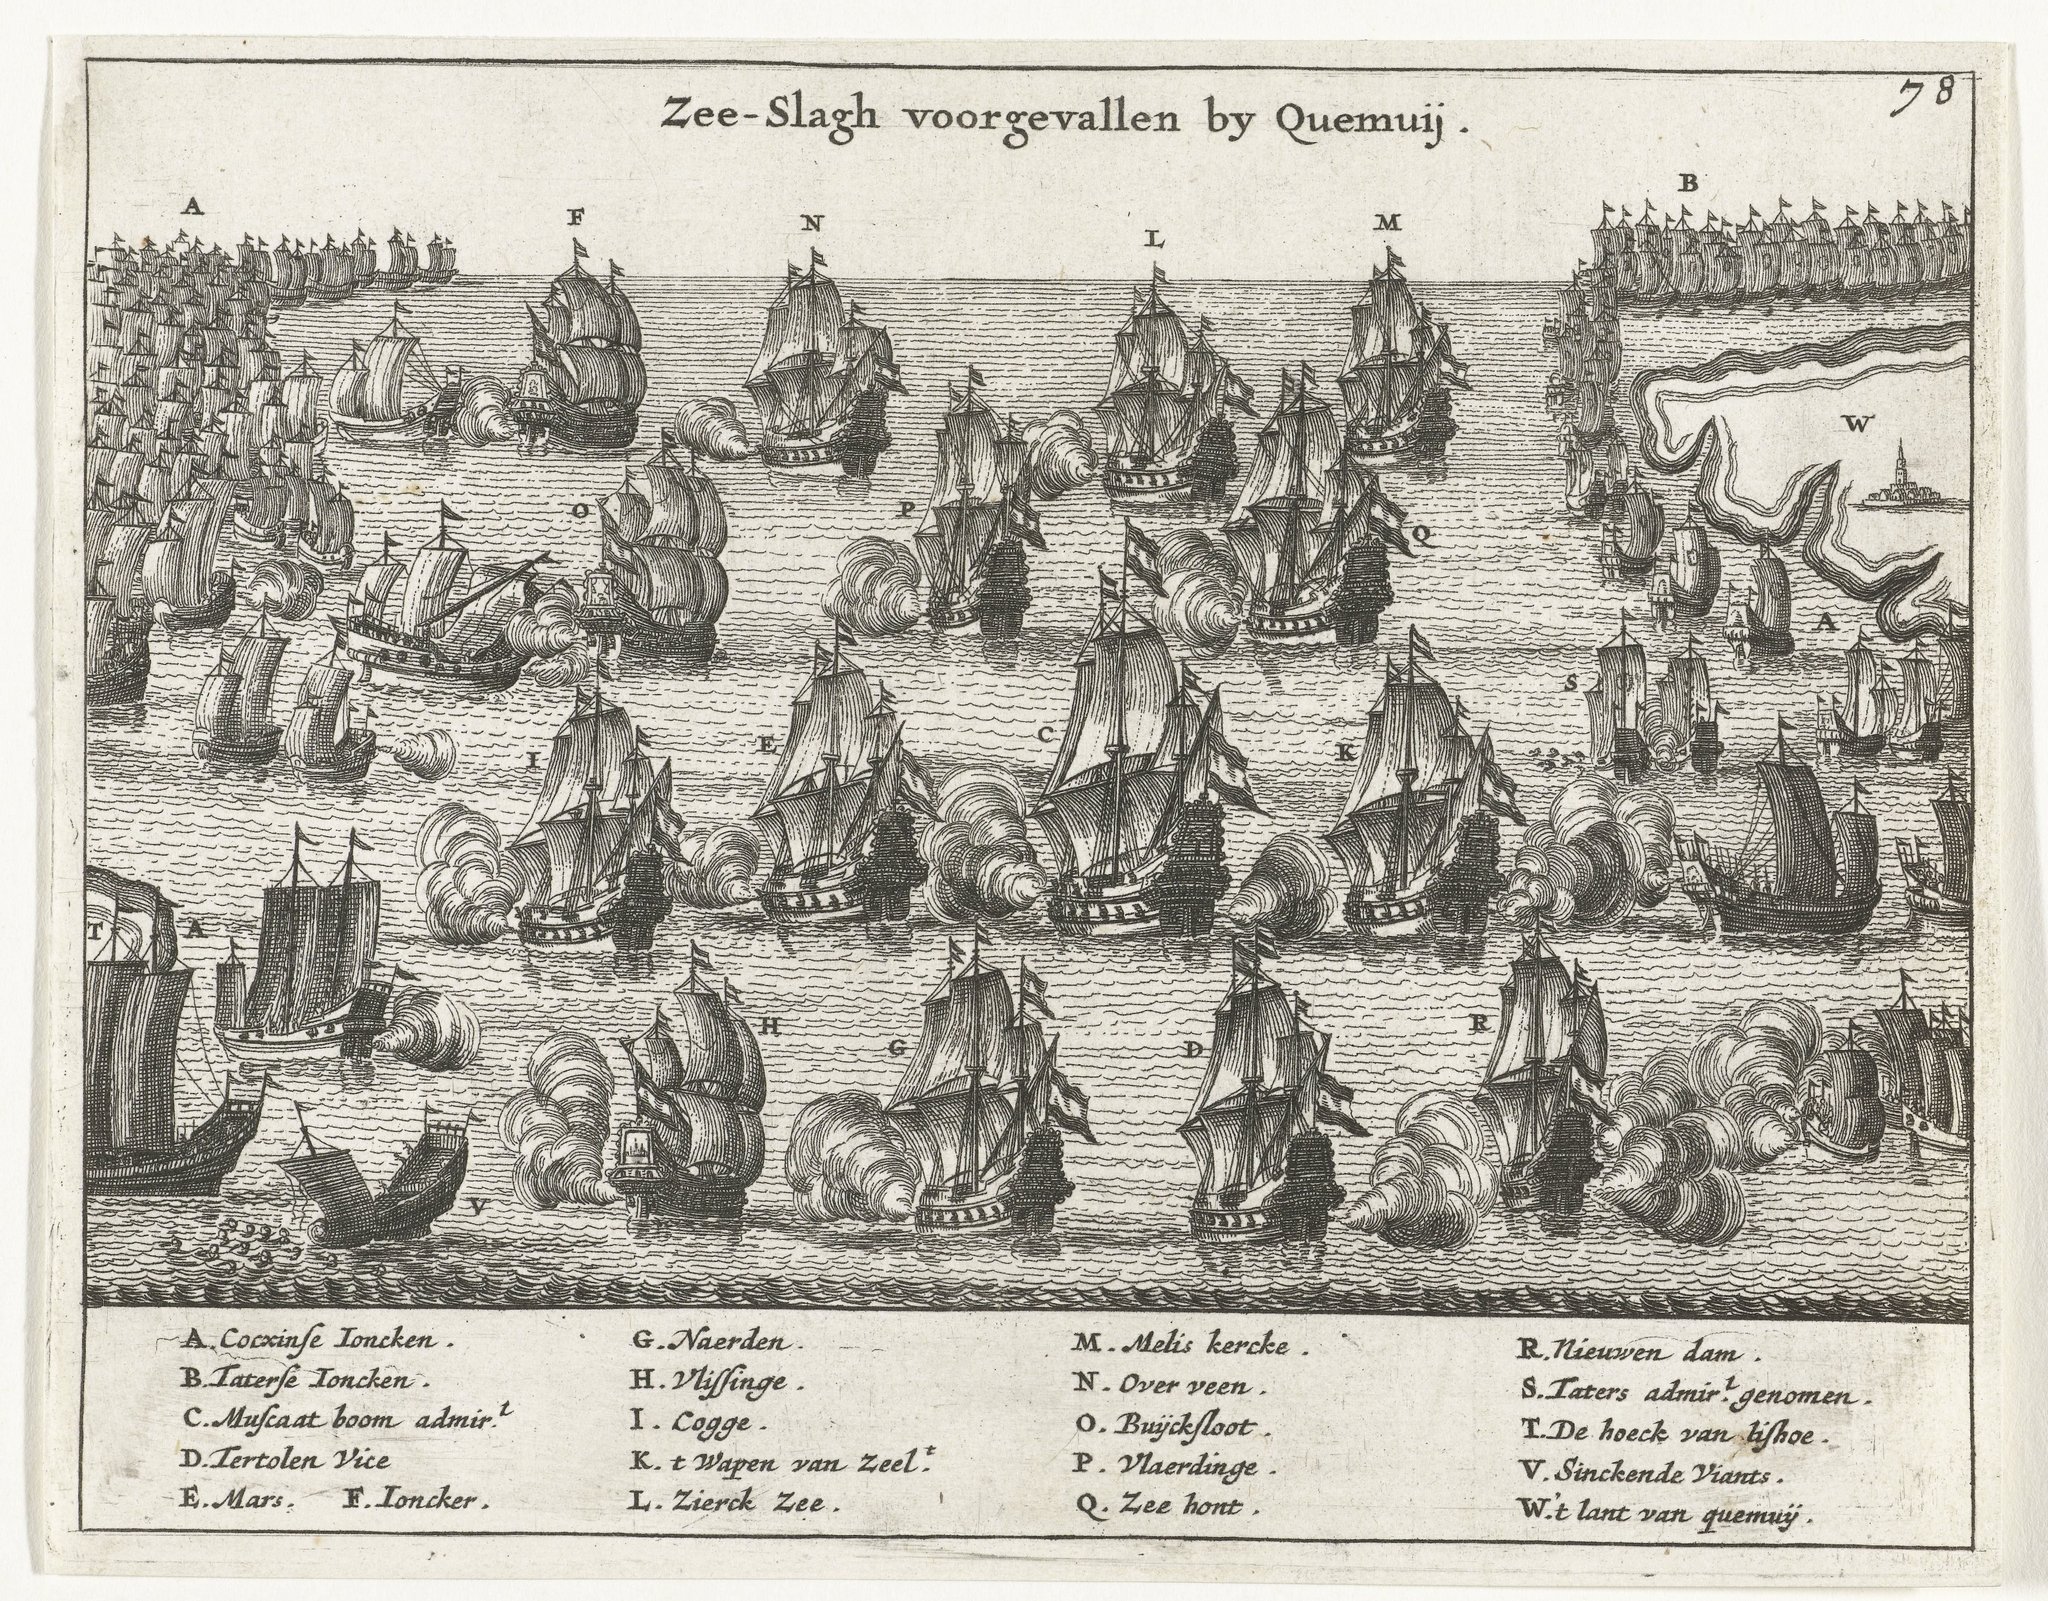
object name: print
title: Battle of Quemoy: Qing and Dutch against Ming loyalists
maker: Anonymous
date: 1670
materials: paper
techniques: etching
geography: northern netherlands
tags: japan, sailing-ship, sailing-boat, battle (+ naval force), china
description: De Hollandse vloot in een zeeslag bij Quemuy (China, één van de Kinmen-eilanden), 19 november 1663. In verband met de expedities van de VOC van 1662-1665 onder leiding van Balthasar Bort tegen de Chinese krijgsheer Coxinga. In het onderschrift de legenda A-W. Gemerkt rechtsboven: 78.